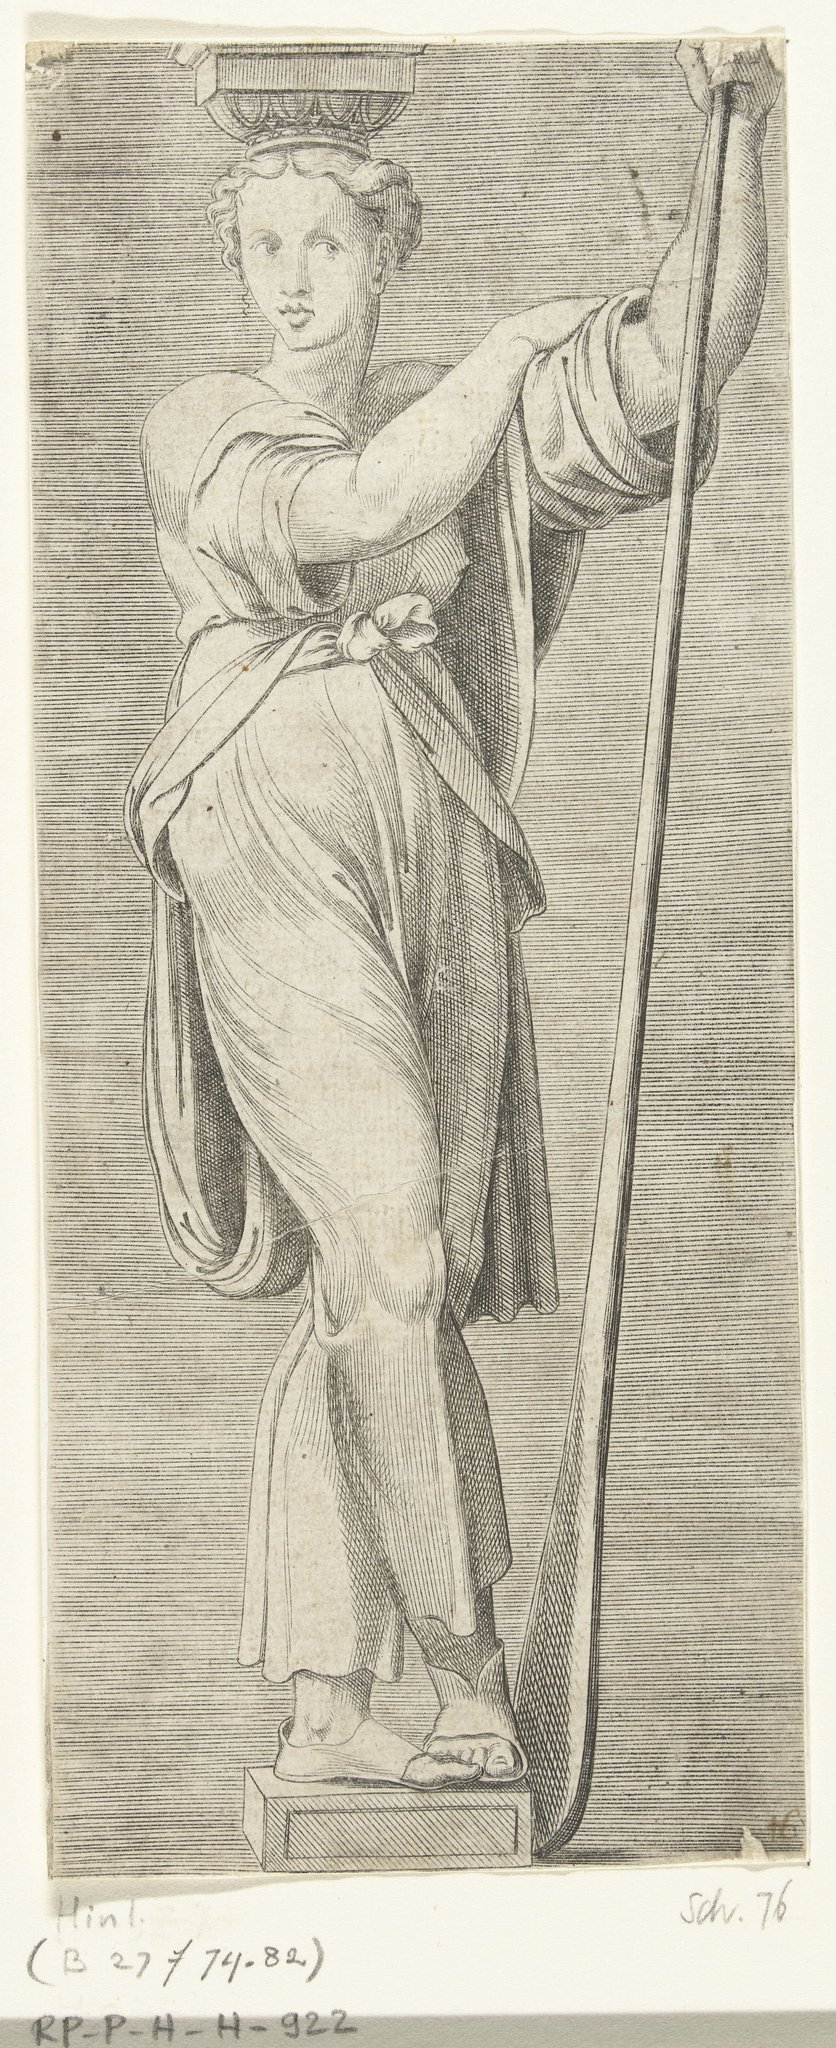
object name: print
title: Kariatide met roeispan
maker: cornelis bos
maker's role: print maker, printer, publisher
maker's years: 1510-1566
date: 1537-1555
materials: paper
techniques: engraving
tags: caryatids ~ architecture, trade, commerce and finance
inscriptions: collector's mark: Lugt 10, number: Lugt 46, collector's mark: 11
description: Een kariatide, staand met gekruiste benen en steunend op een roeispan, symboliseert de maritime handel.